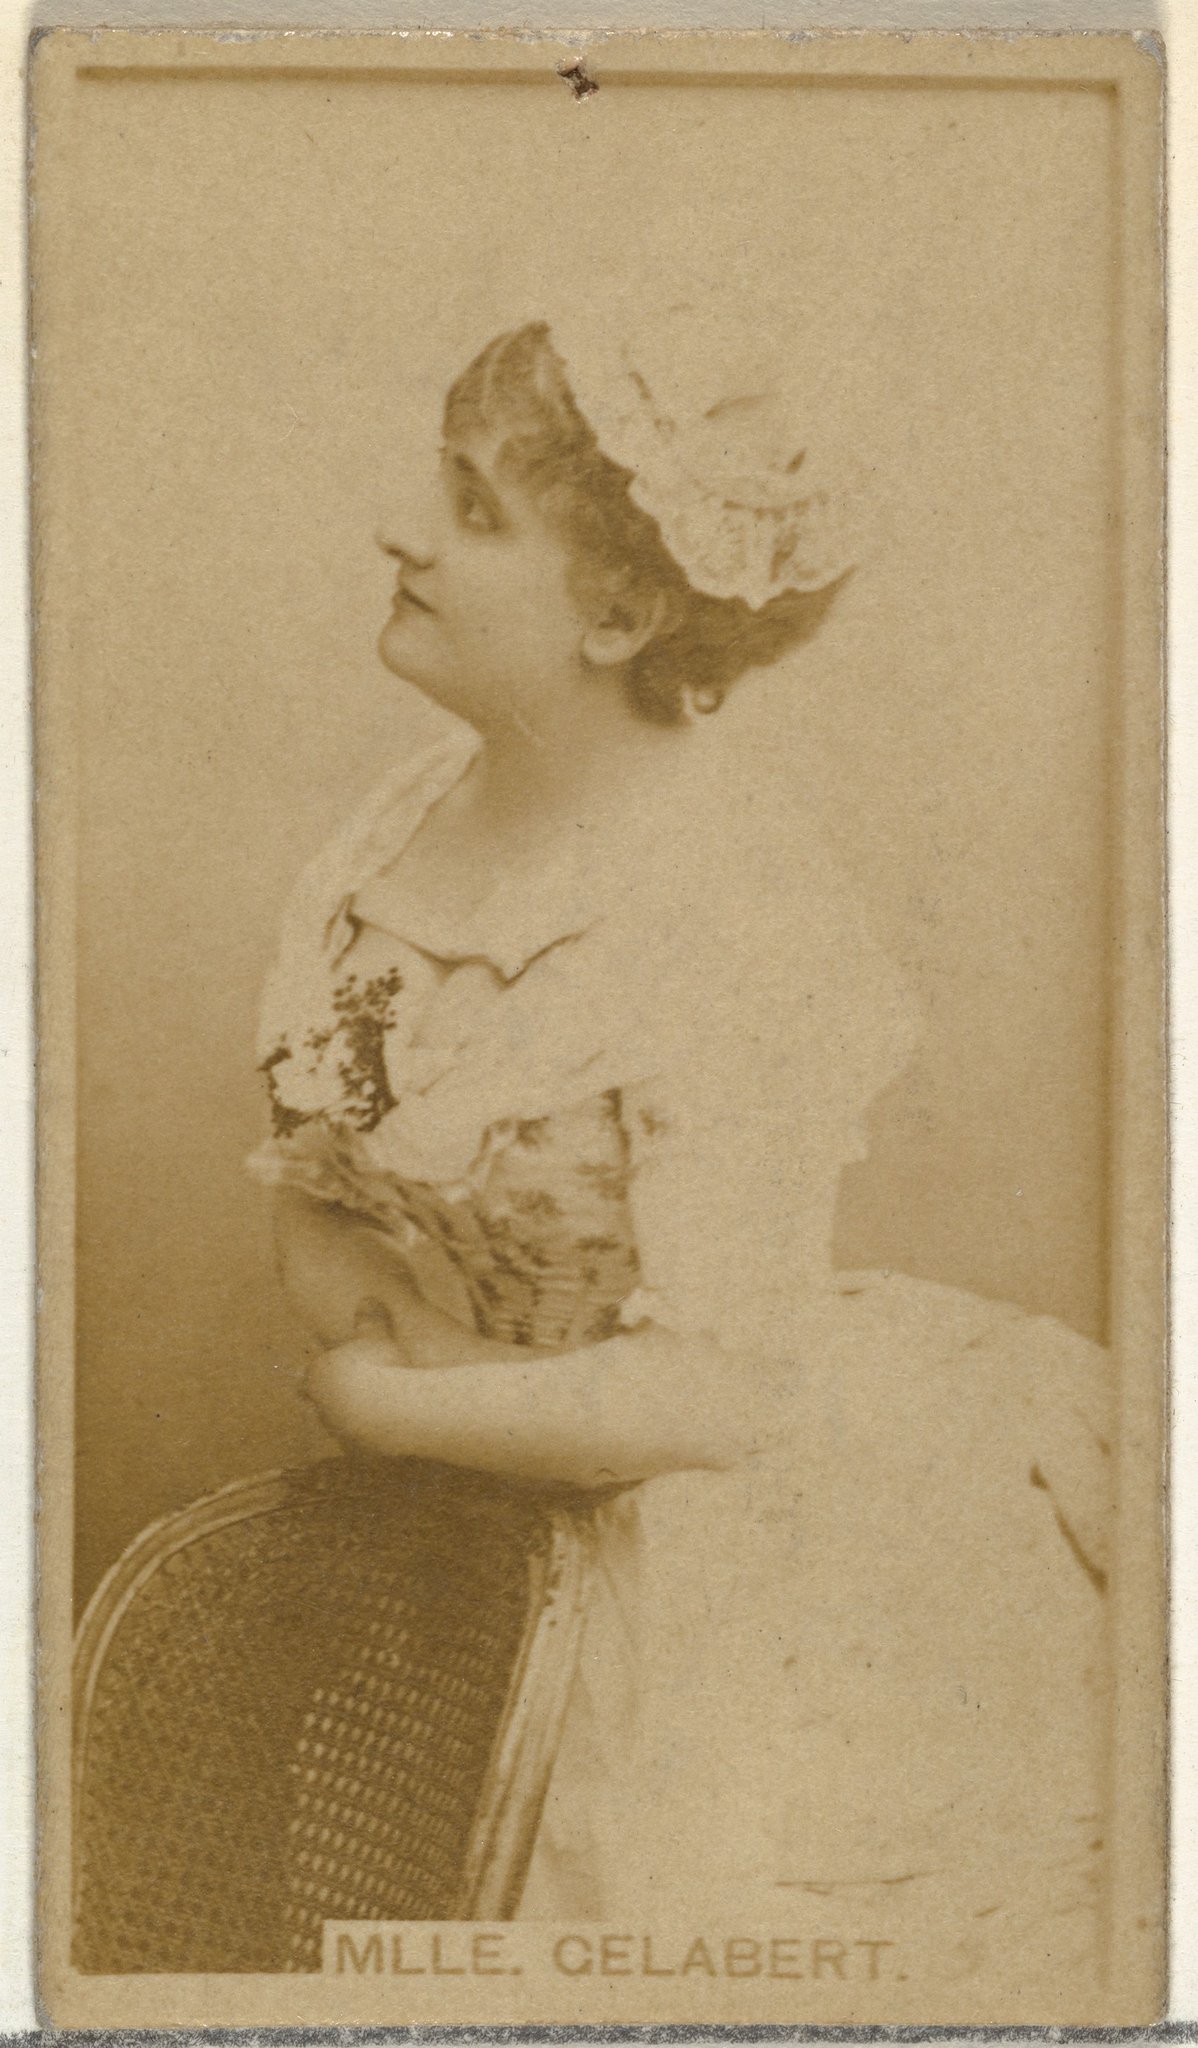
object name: photograph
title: Mlle. Gelabert, from the Actors and Actresses series (N145-8) issued by Duke Sons & Co. to promote Duke Cigarettes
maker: w. duke, sons & co.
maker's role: publisher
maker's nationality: american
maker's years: 1870-1920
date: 1891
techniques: albumen silver print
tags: portraits,women,actresses